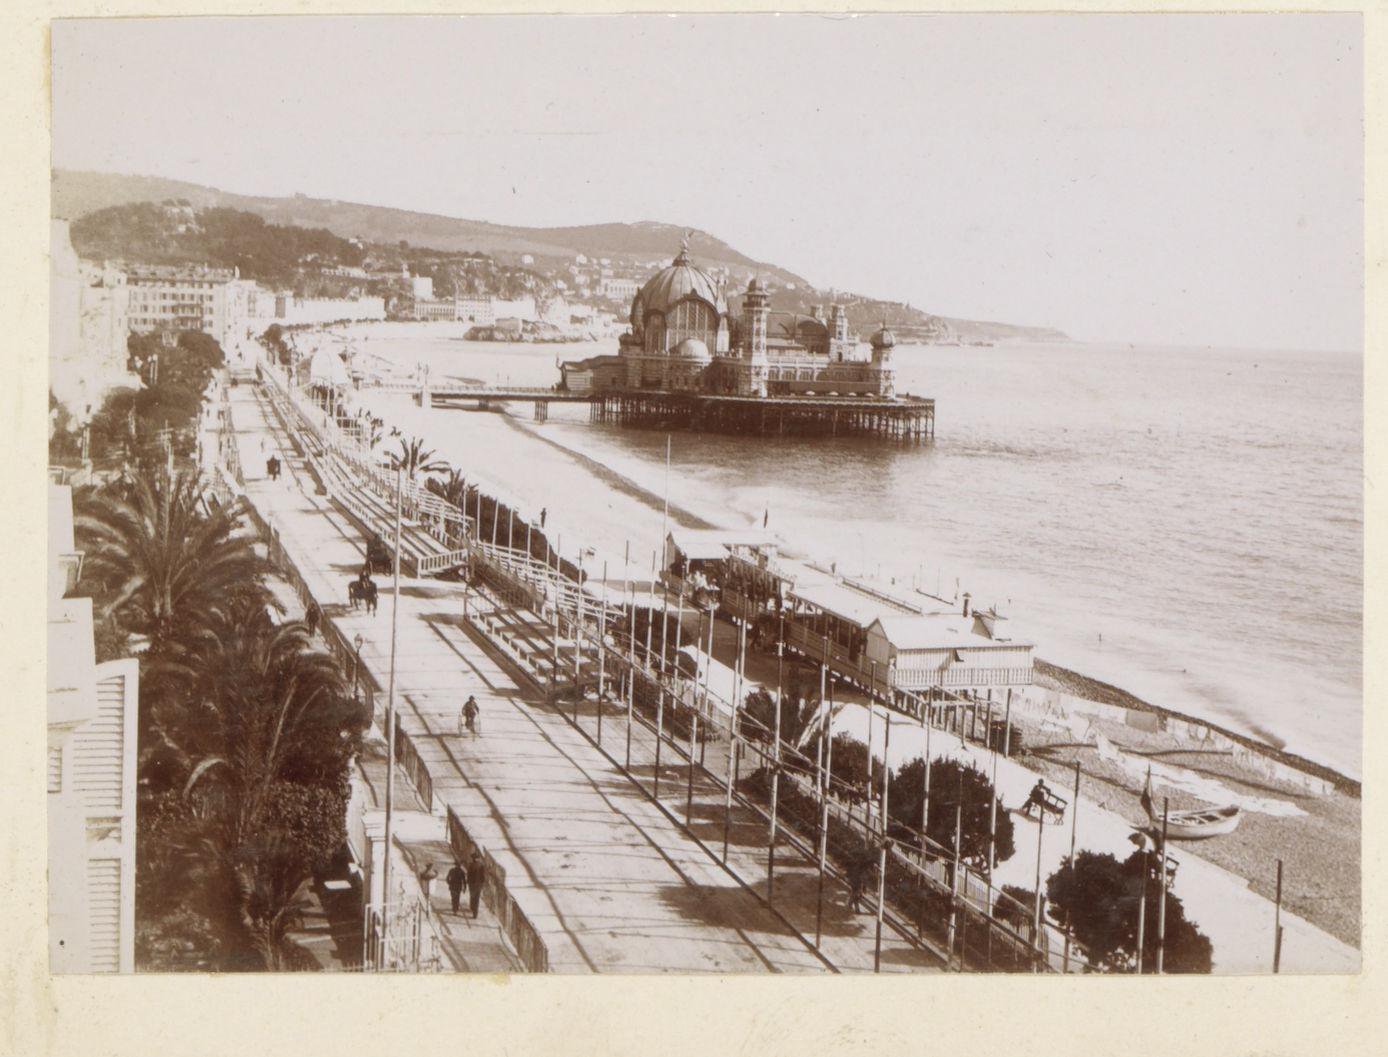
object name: photograph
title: Gezicht op de Promenade des Anglais en de pier van Nice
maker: Anonymous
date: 1900-1910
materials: paper, photographic support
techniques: daylight paper print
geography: southern france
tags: avenue, boulevard, promenade, esplanade (+ city(-scape) with figures, staffage), pier, quay, wharf, prospect of city, town panorama, silhouette of city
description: Onderdeel van Fotoalbum van een Franse amateurfotograaf met opnames van een familie, distilleerderij Delizy & Doistau Fils, het leger en bezienswaardigheden in Frankrijk.